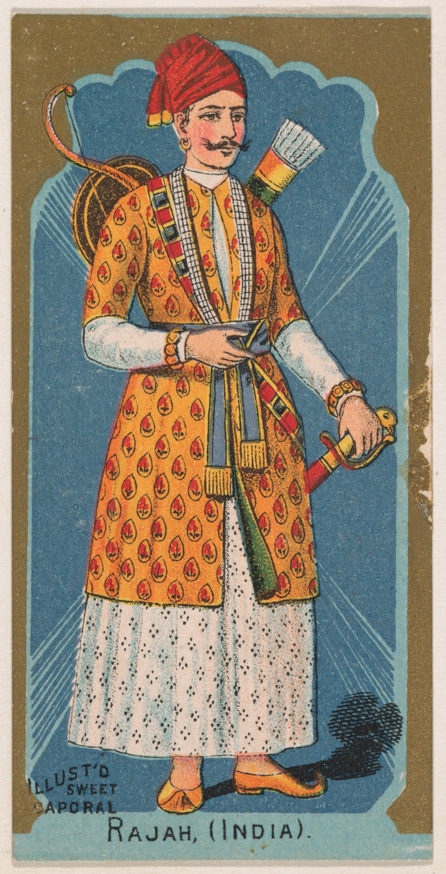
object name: print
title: Rajah, India, from the Military Series (N224) issued by Kinney Tobacco Company to promote Sweet Caporal Cigarettes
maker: kinney brothers tobacco company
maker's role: publisher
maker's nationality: american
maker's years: 1869-2011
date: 1888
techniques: color lithograph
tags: military,men